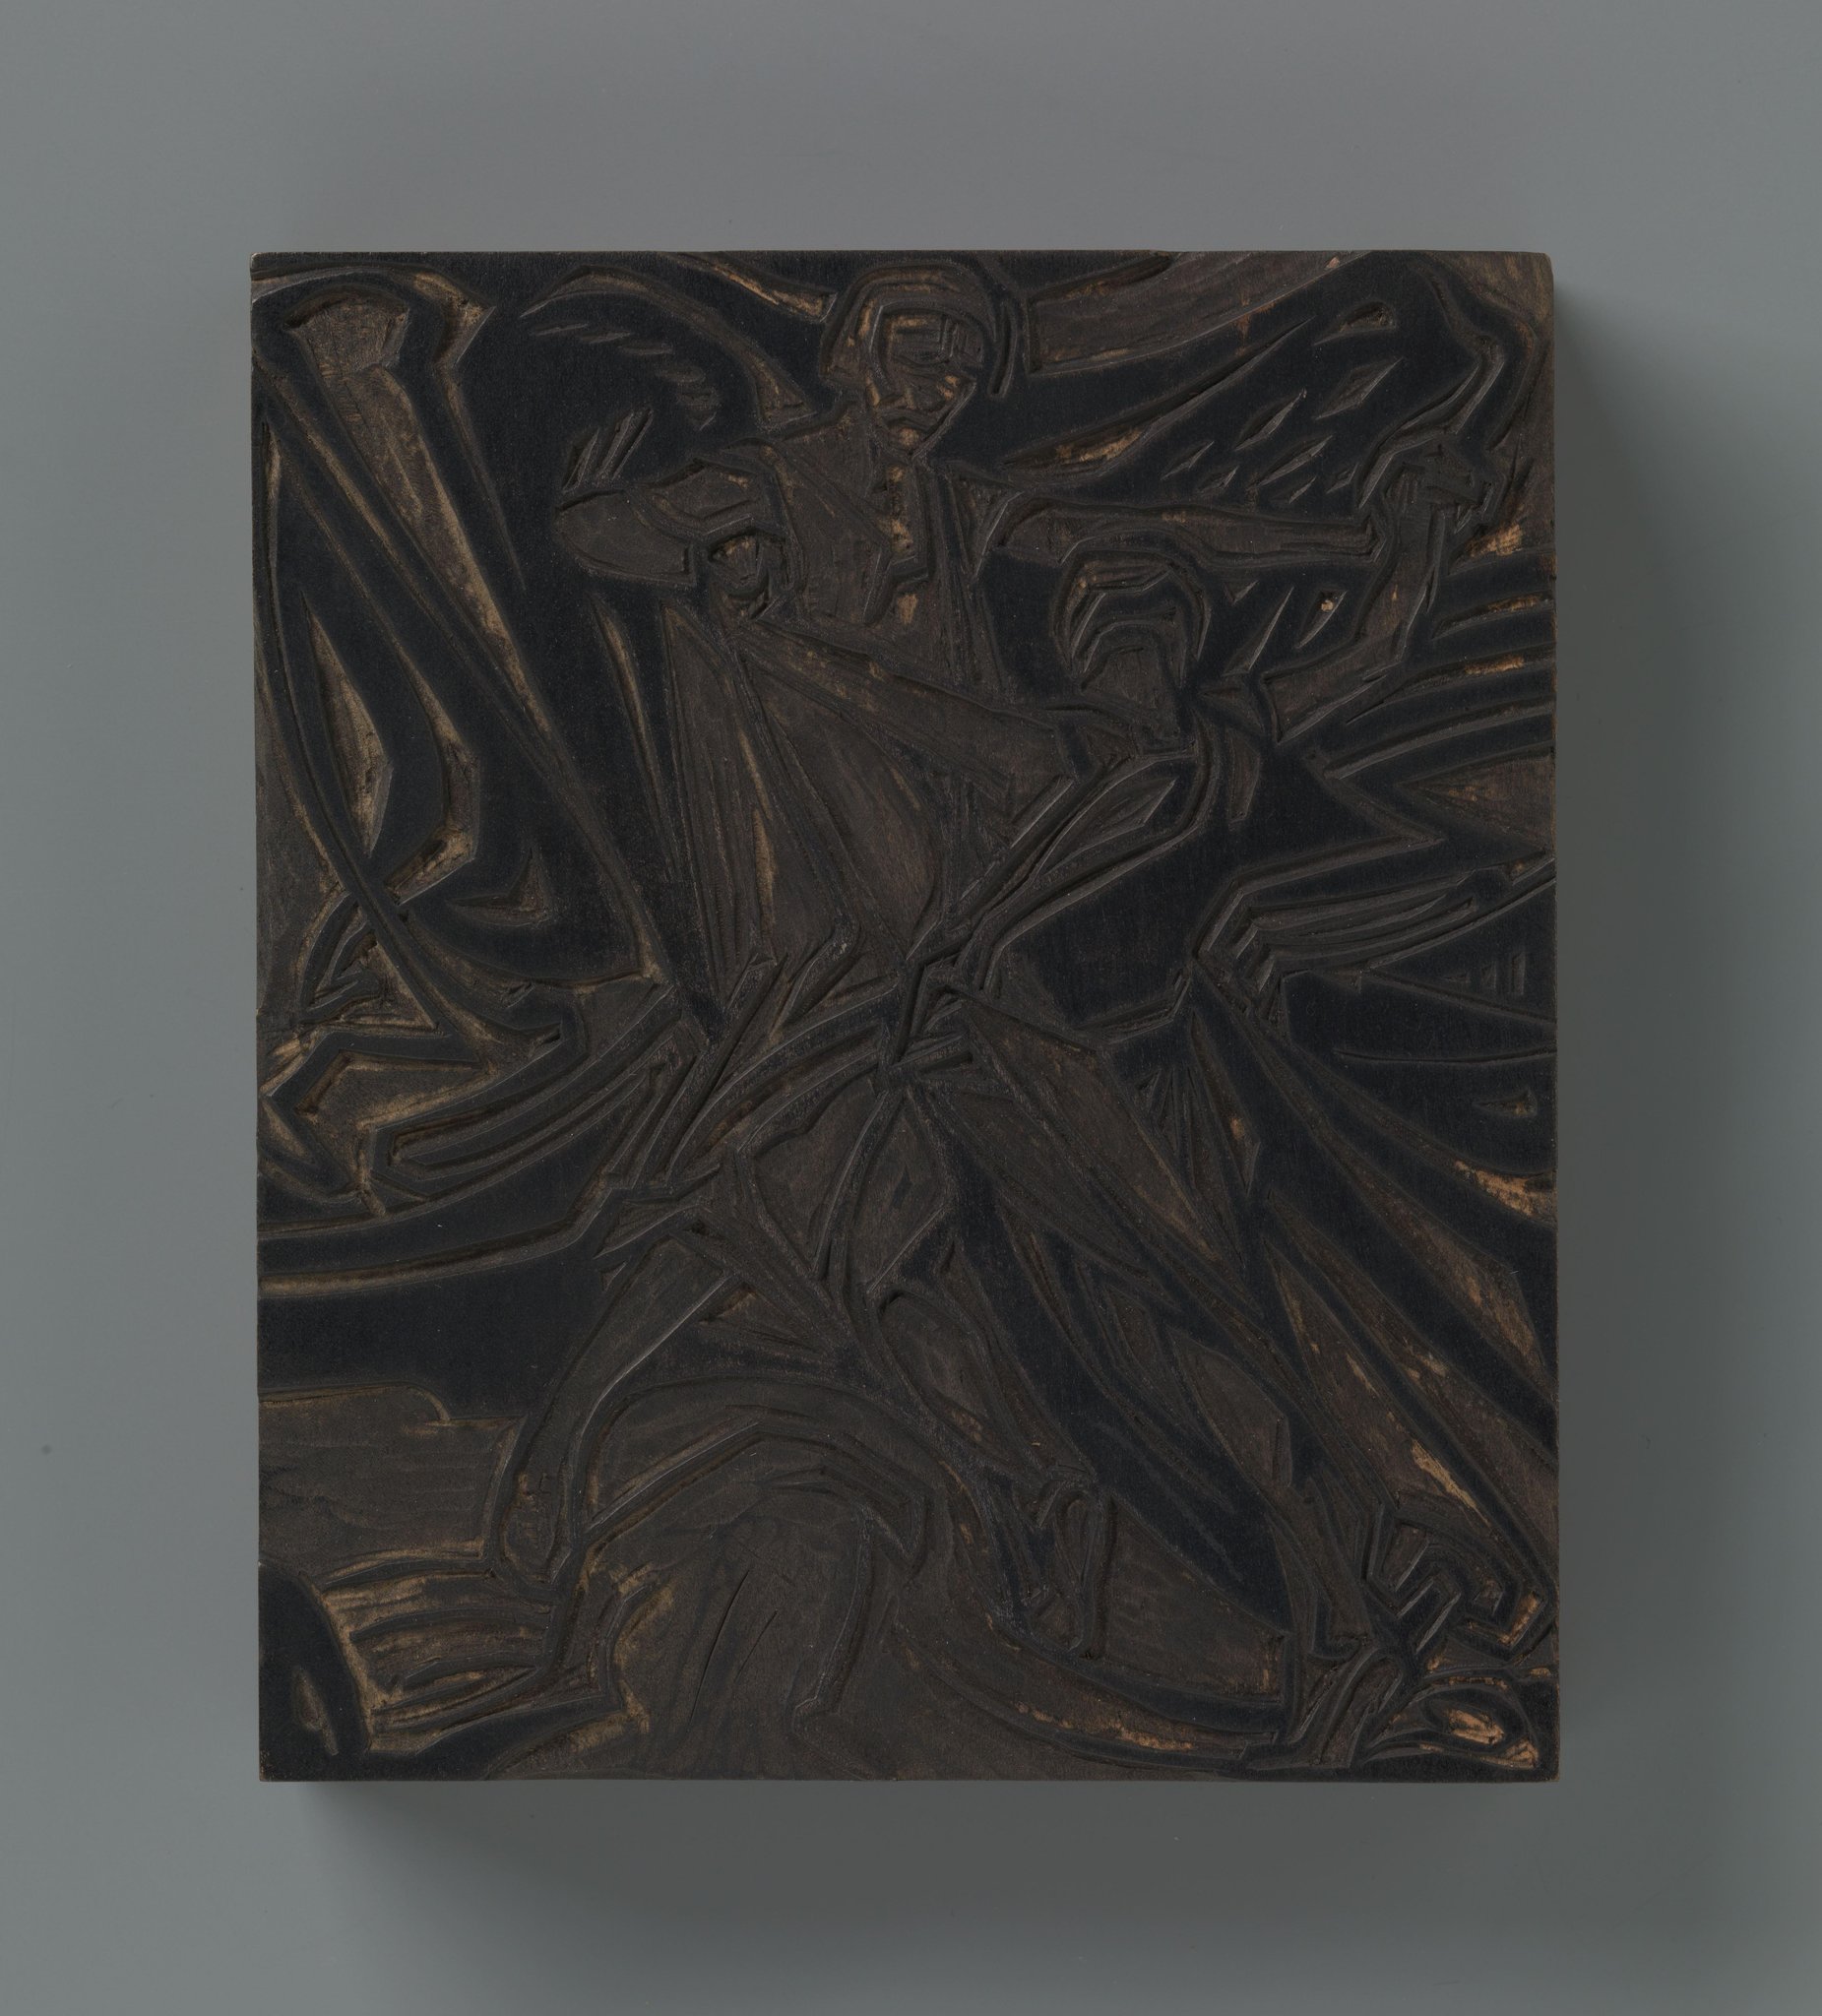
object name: wood block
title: Jakob worstelt met de engel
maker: johannes josephus aarts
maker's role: draughtsman, print maker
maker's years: 1871-1934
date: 1881-1934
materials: wood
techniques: woodcut